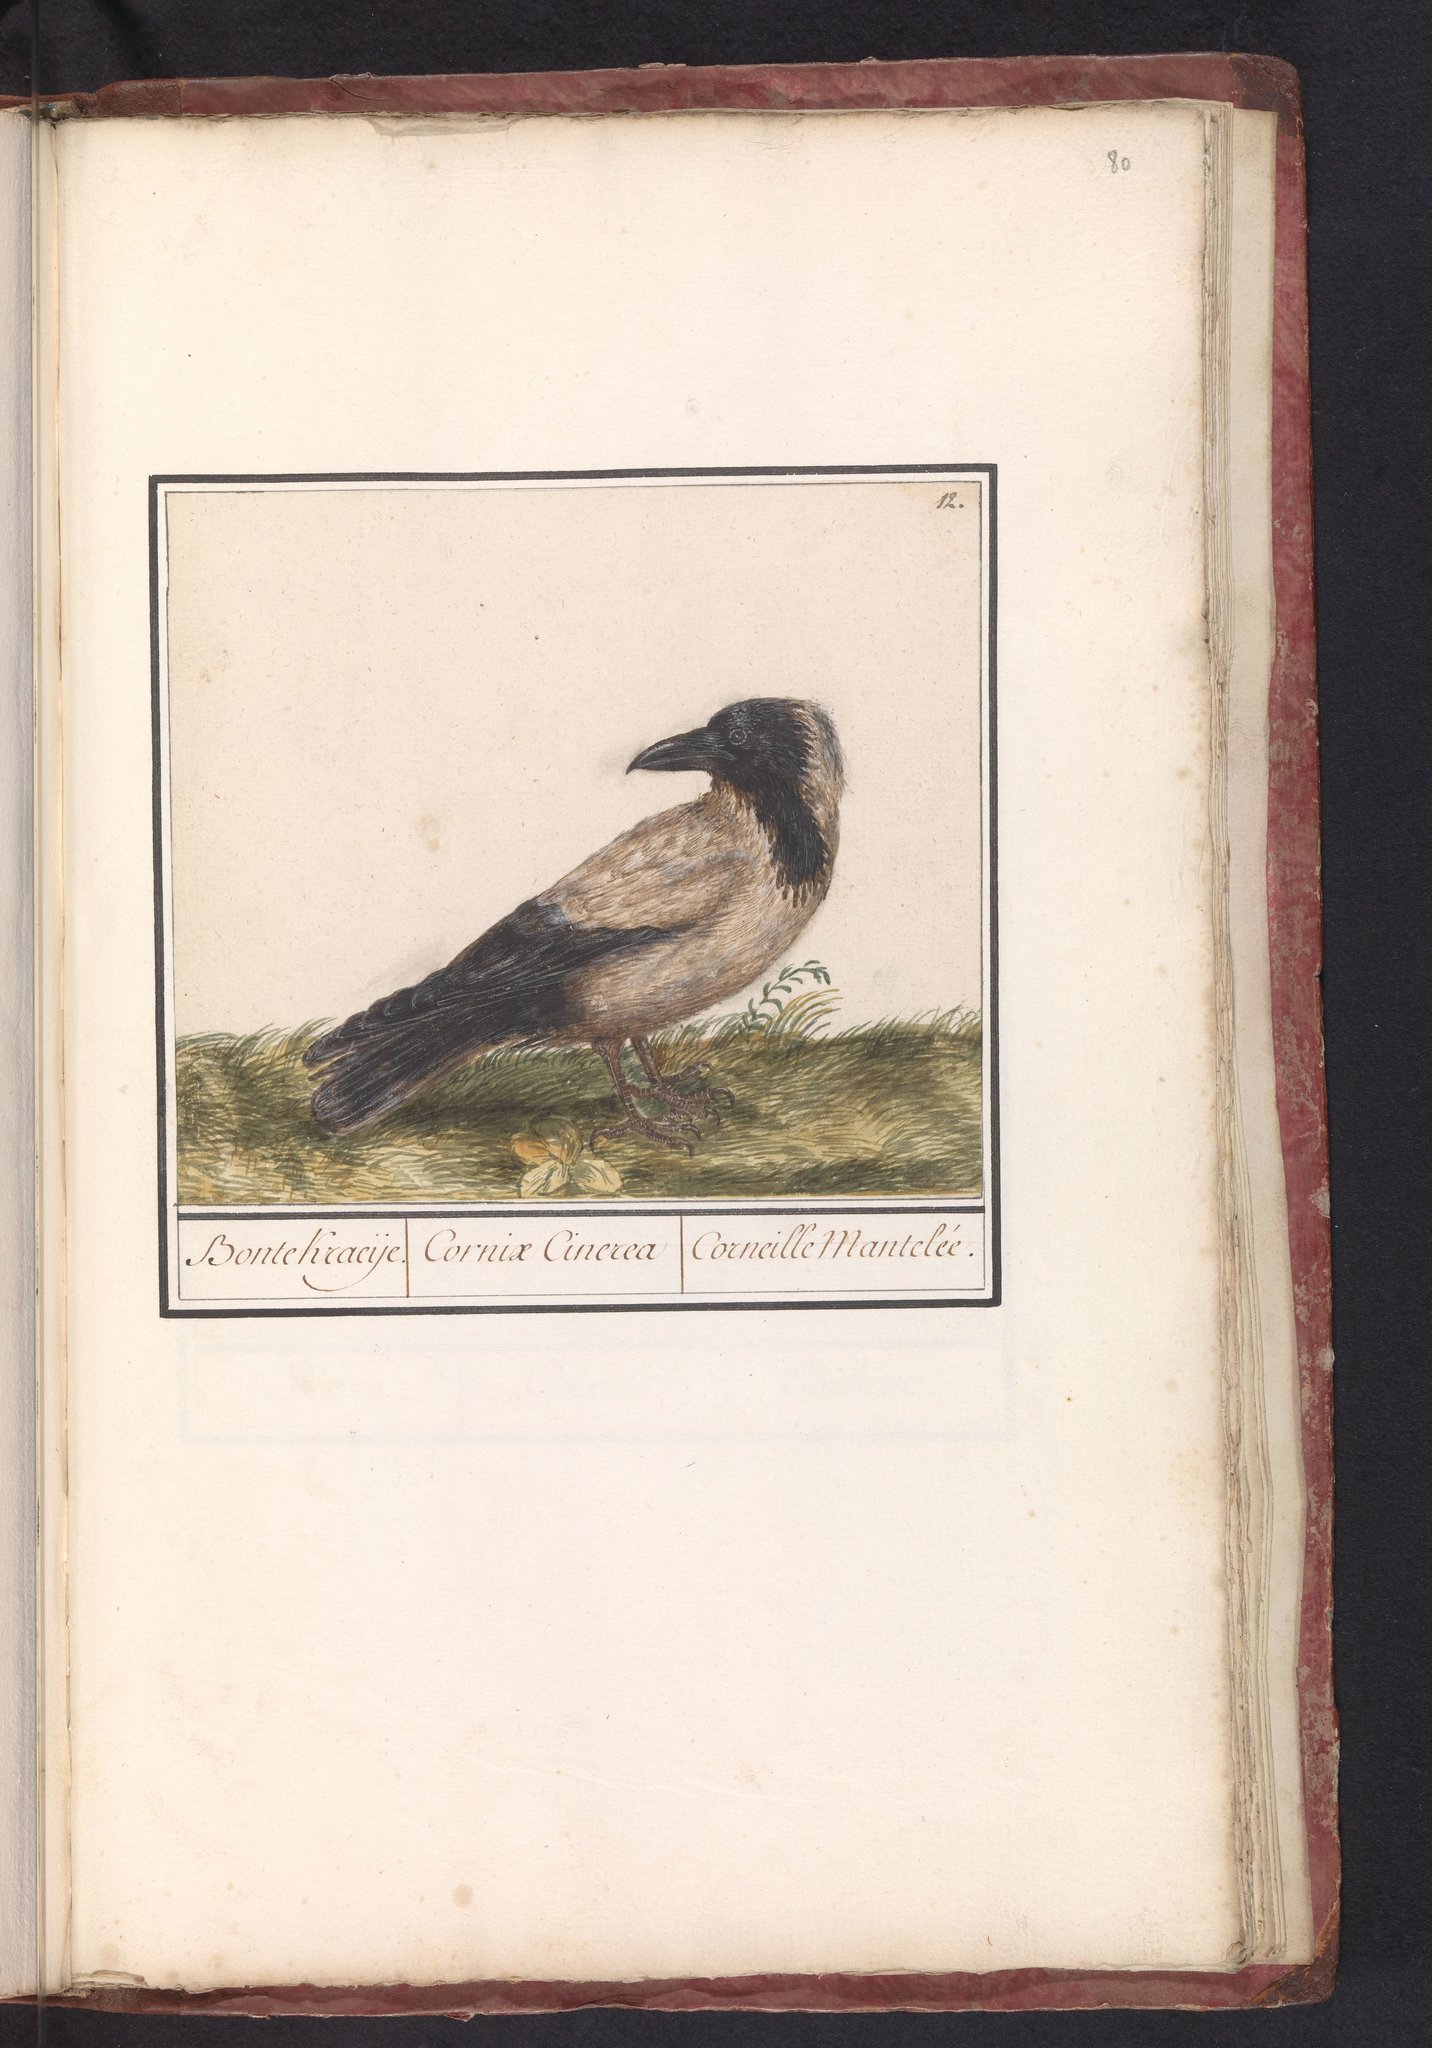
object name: drawing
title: Bonte kraai (Corvus cornix)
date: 1596-1610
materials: paint, paper, pencil, watercolor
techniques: brush, pen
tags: song-birds: hooded crow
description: Bonte kraai. Genummerd rechtsboven: 12. Onderdeel van het eerste album met tekeningen van vogels. Derde van twaalf albums met tekeningen van dieren, vogels en planten bekend rond 1600, gemaakt in opdracht van keizer Rudolf II. Met toelichting in Nederlands, Latijn en Frans.